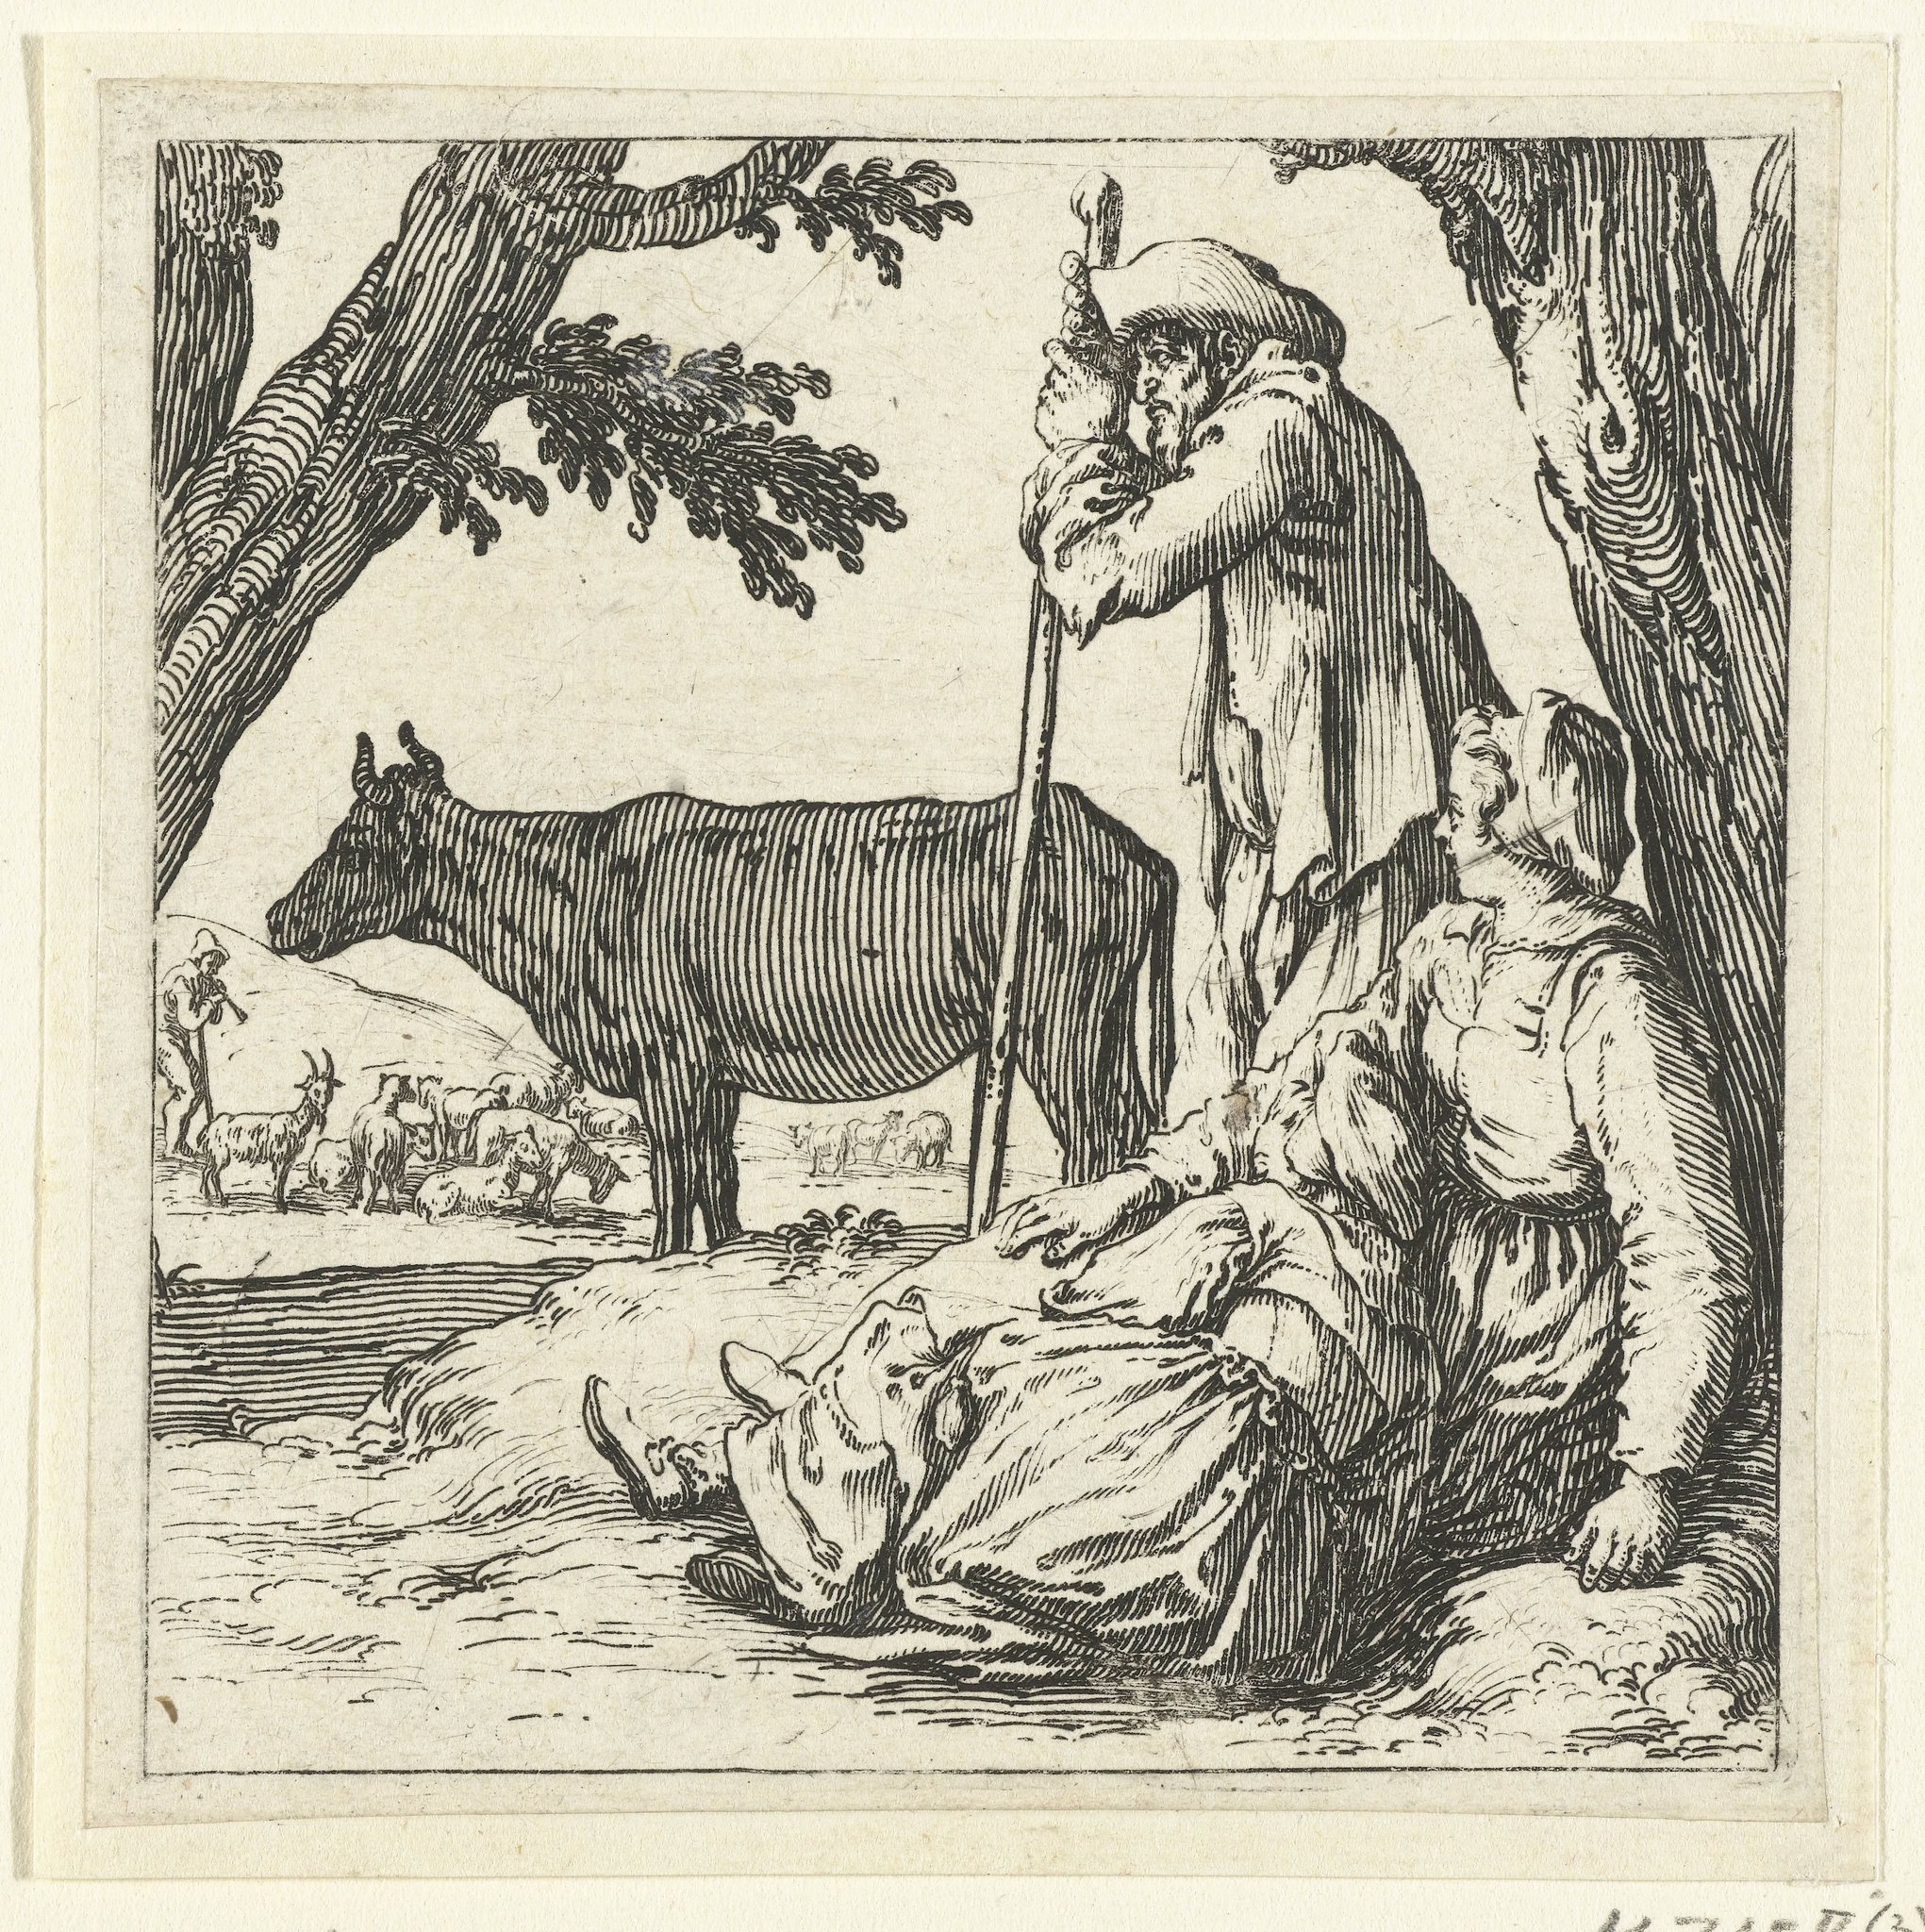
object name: print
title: Diverse figuren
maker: jacques callot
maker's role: draughtsman, print maker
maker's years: 1592-1635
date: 1621-1624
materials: paper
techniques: etching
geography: nancy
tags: cow, parents with their children, farmers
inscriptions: collector's mark: Lugt 240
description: Een boer, een boerin en een meisje rusten uit bij een boom. Naast hen staat een koe. Op de achtergrond een geitenhoeder. Deze prent is onderdeel van een serie van 16 prenten (15 volgens Lieure; 17 resp. 16 incl. titelprent) met mannen en vrouwen in diverse houdingen. Mogelijk zijn deze prenten bedoeld geweest als tekenvoorbeelden.